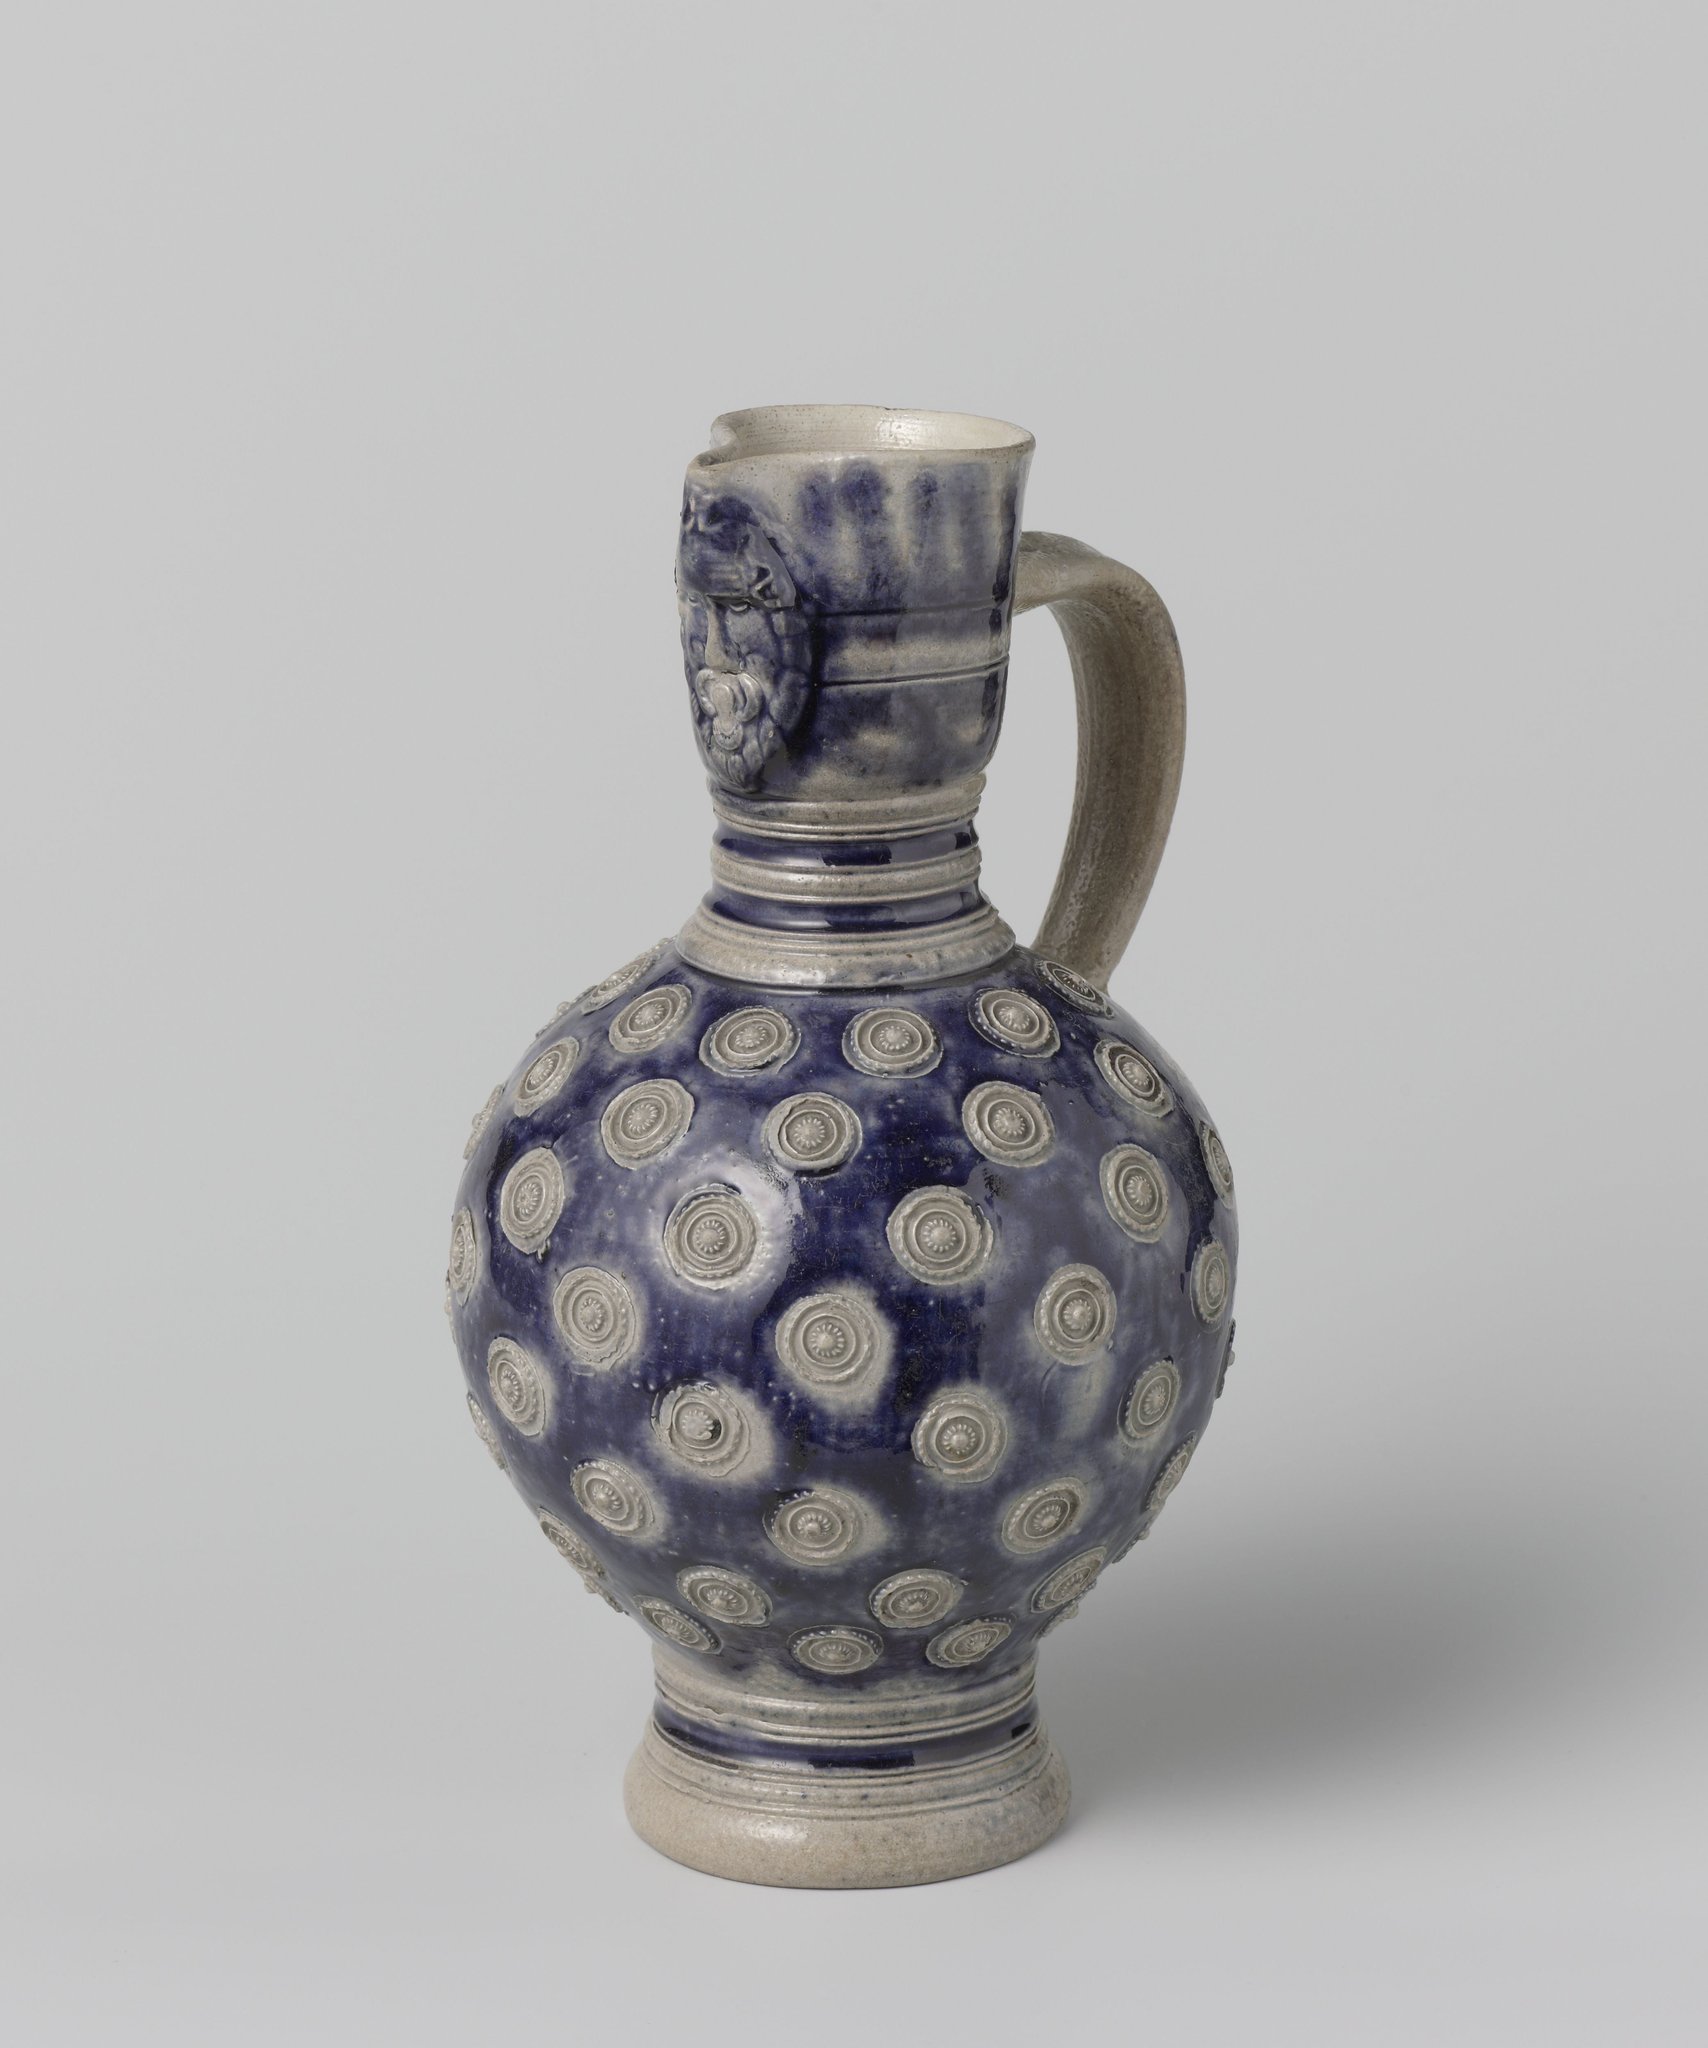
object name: ewer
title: Jug with a mask and medallions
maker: Anonymous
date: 1630-1700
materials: cobalt, glaze, stoneware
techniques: firing, forming, relief, turning, vitrification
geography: westerwald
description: Kan van steengoed op hoge voet met een eivormig lichaam en smalle nek met een geknepen tuit. Het C-vormige oor is bevestigd aan de nek en de schouder. Profielen op de nek en voet. Gedeeltelijk bedekt met kobaltblauw. De kan is versierd met een reliëfdecoratie waarbij de buik grotendeels is bedekt met gedrukte, opgelegde medaillons met een bloemrozet tegen een blauwe achtergrond. Op de nek onder de tuit is een gemodelleerd masker aangebracht. Westerwald.